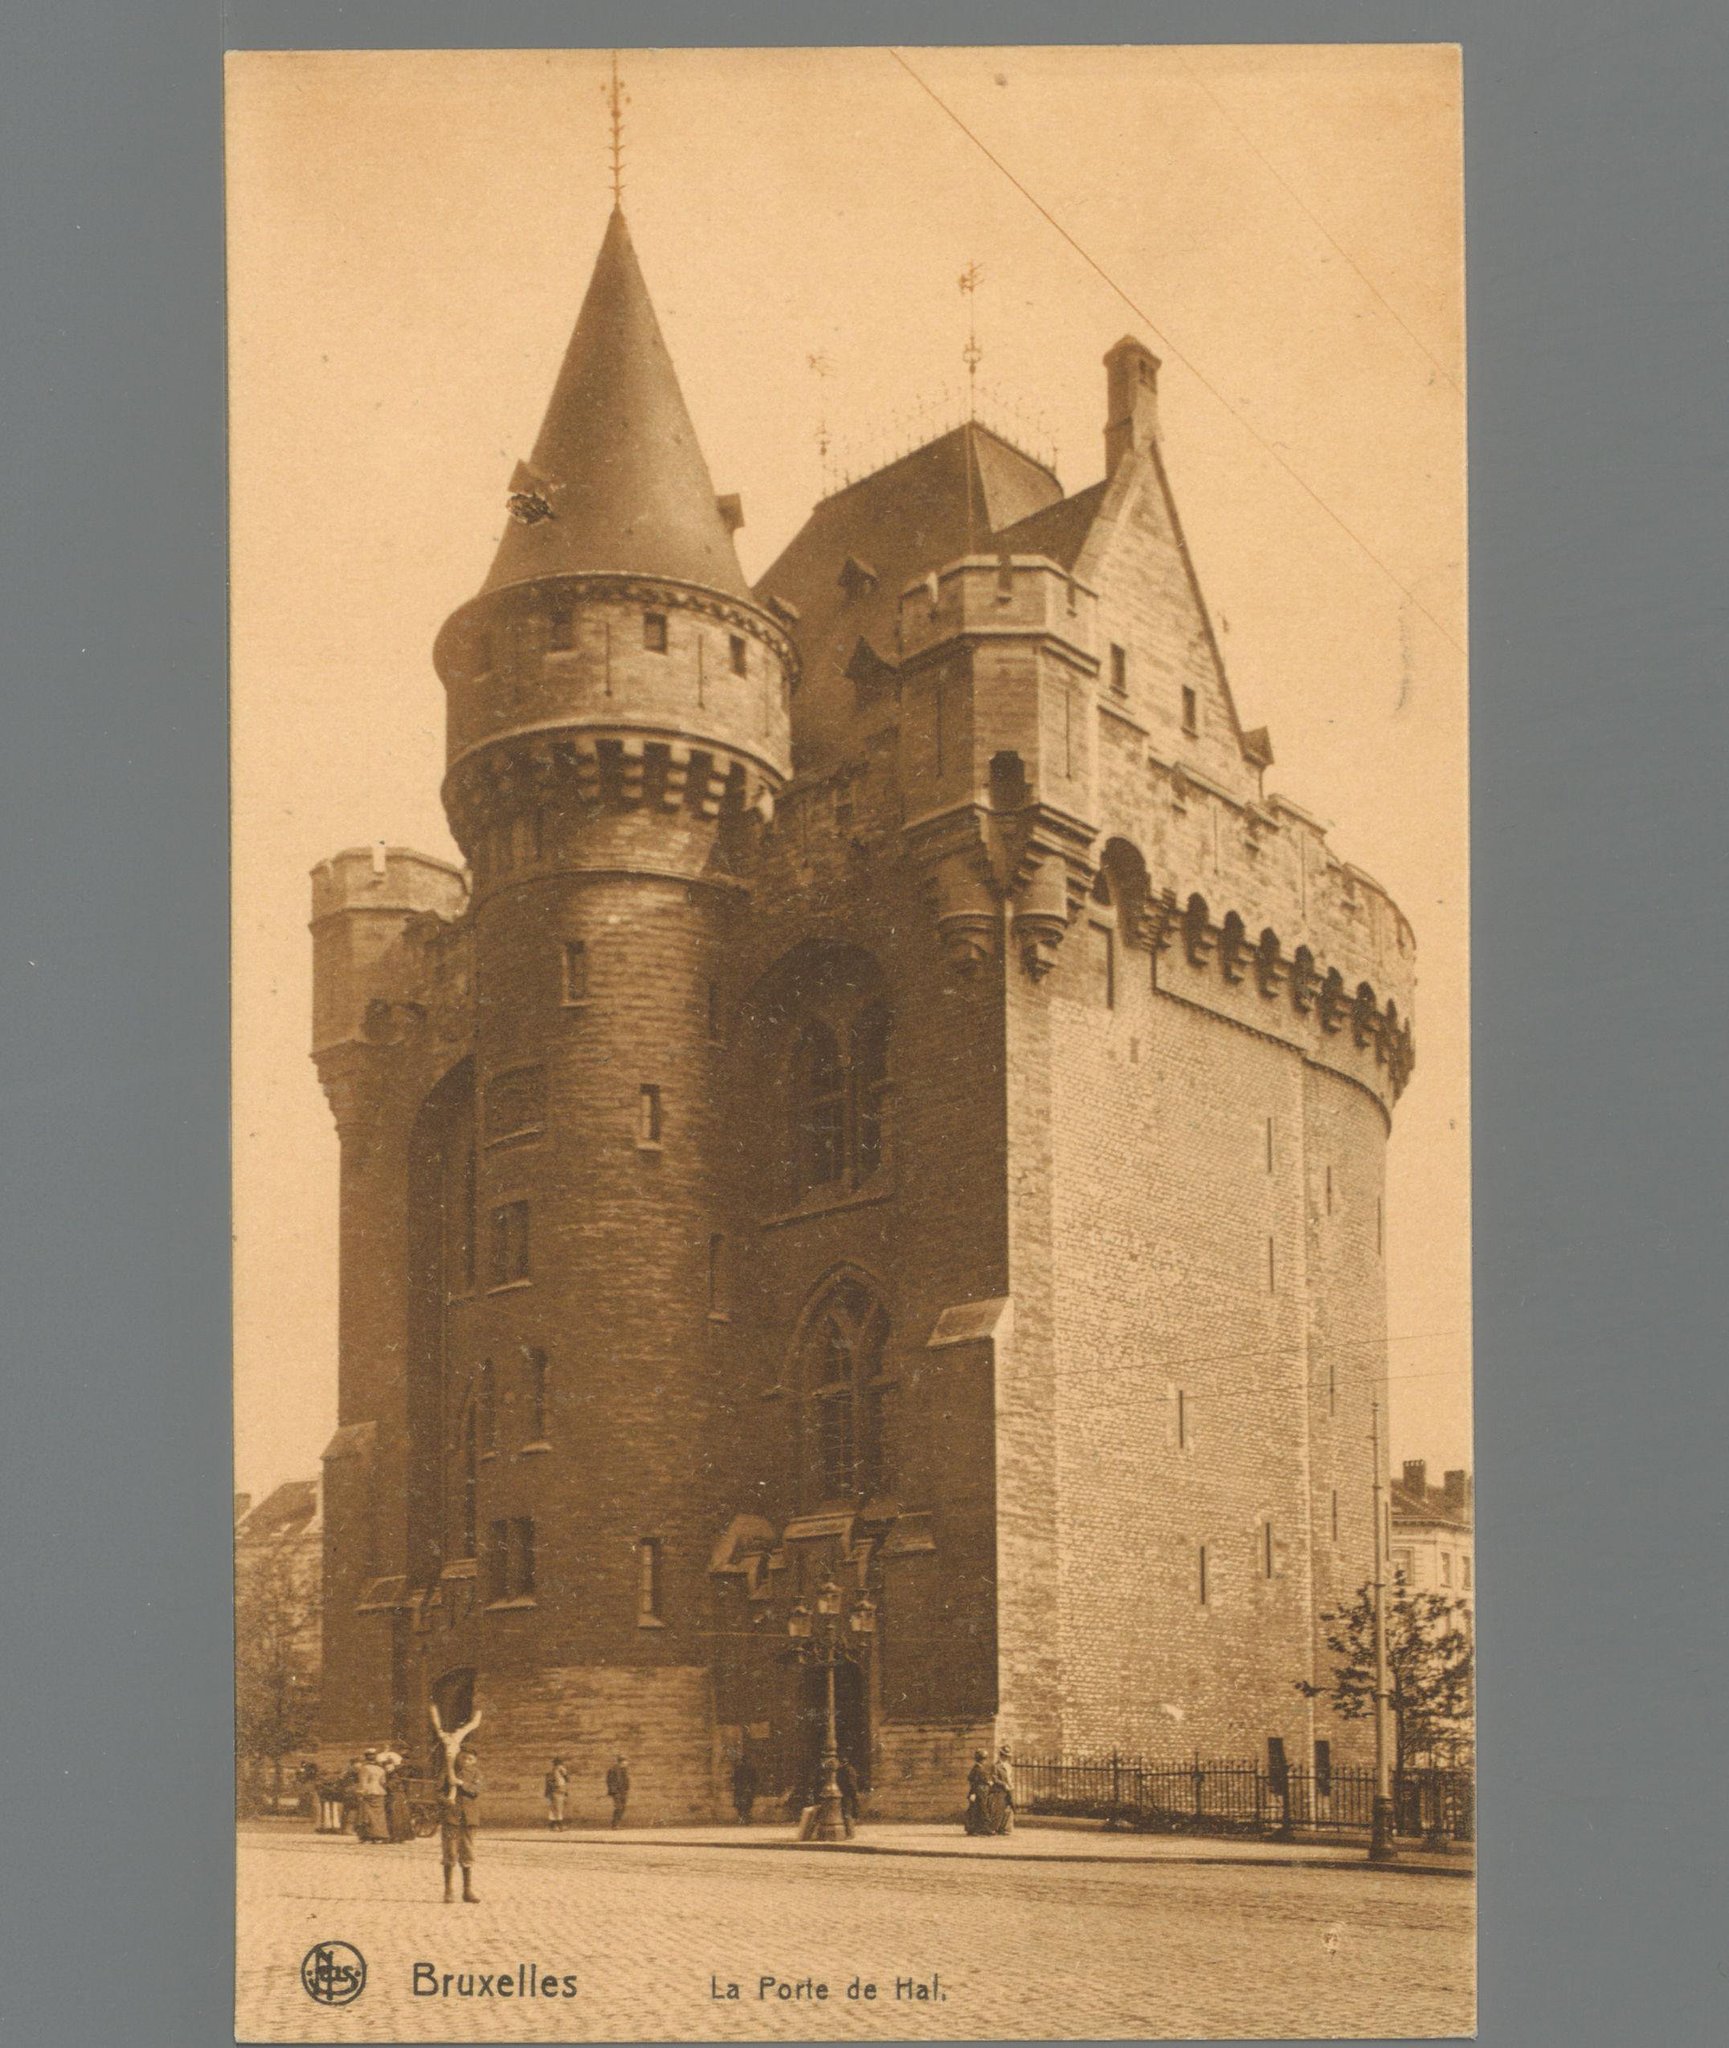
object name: photomechanical print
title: La Porte de Hal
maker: Anonymous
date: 1907-1913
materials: cardboard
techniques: photograph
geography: brussels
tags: city-gate, city-view, and landscape with man-made constructions (+ city(-scape) with figures, staffage)